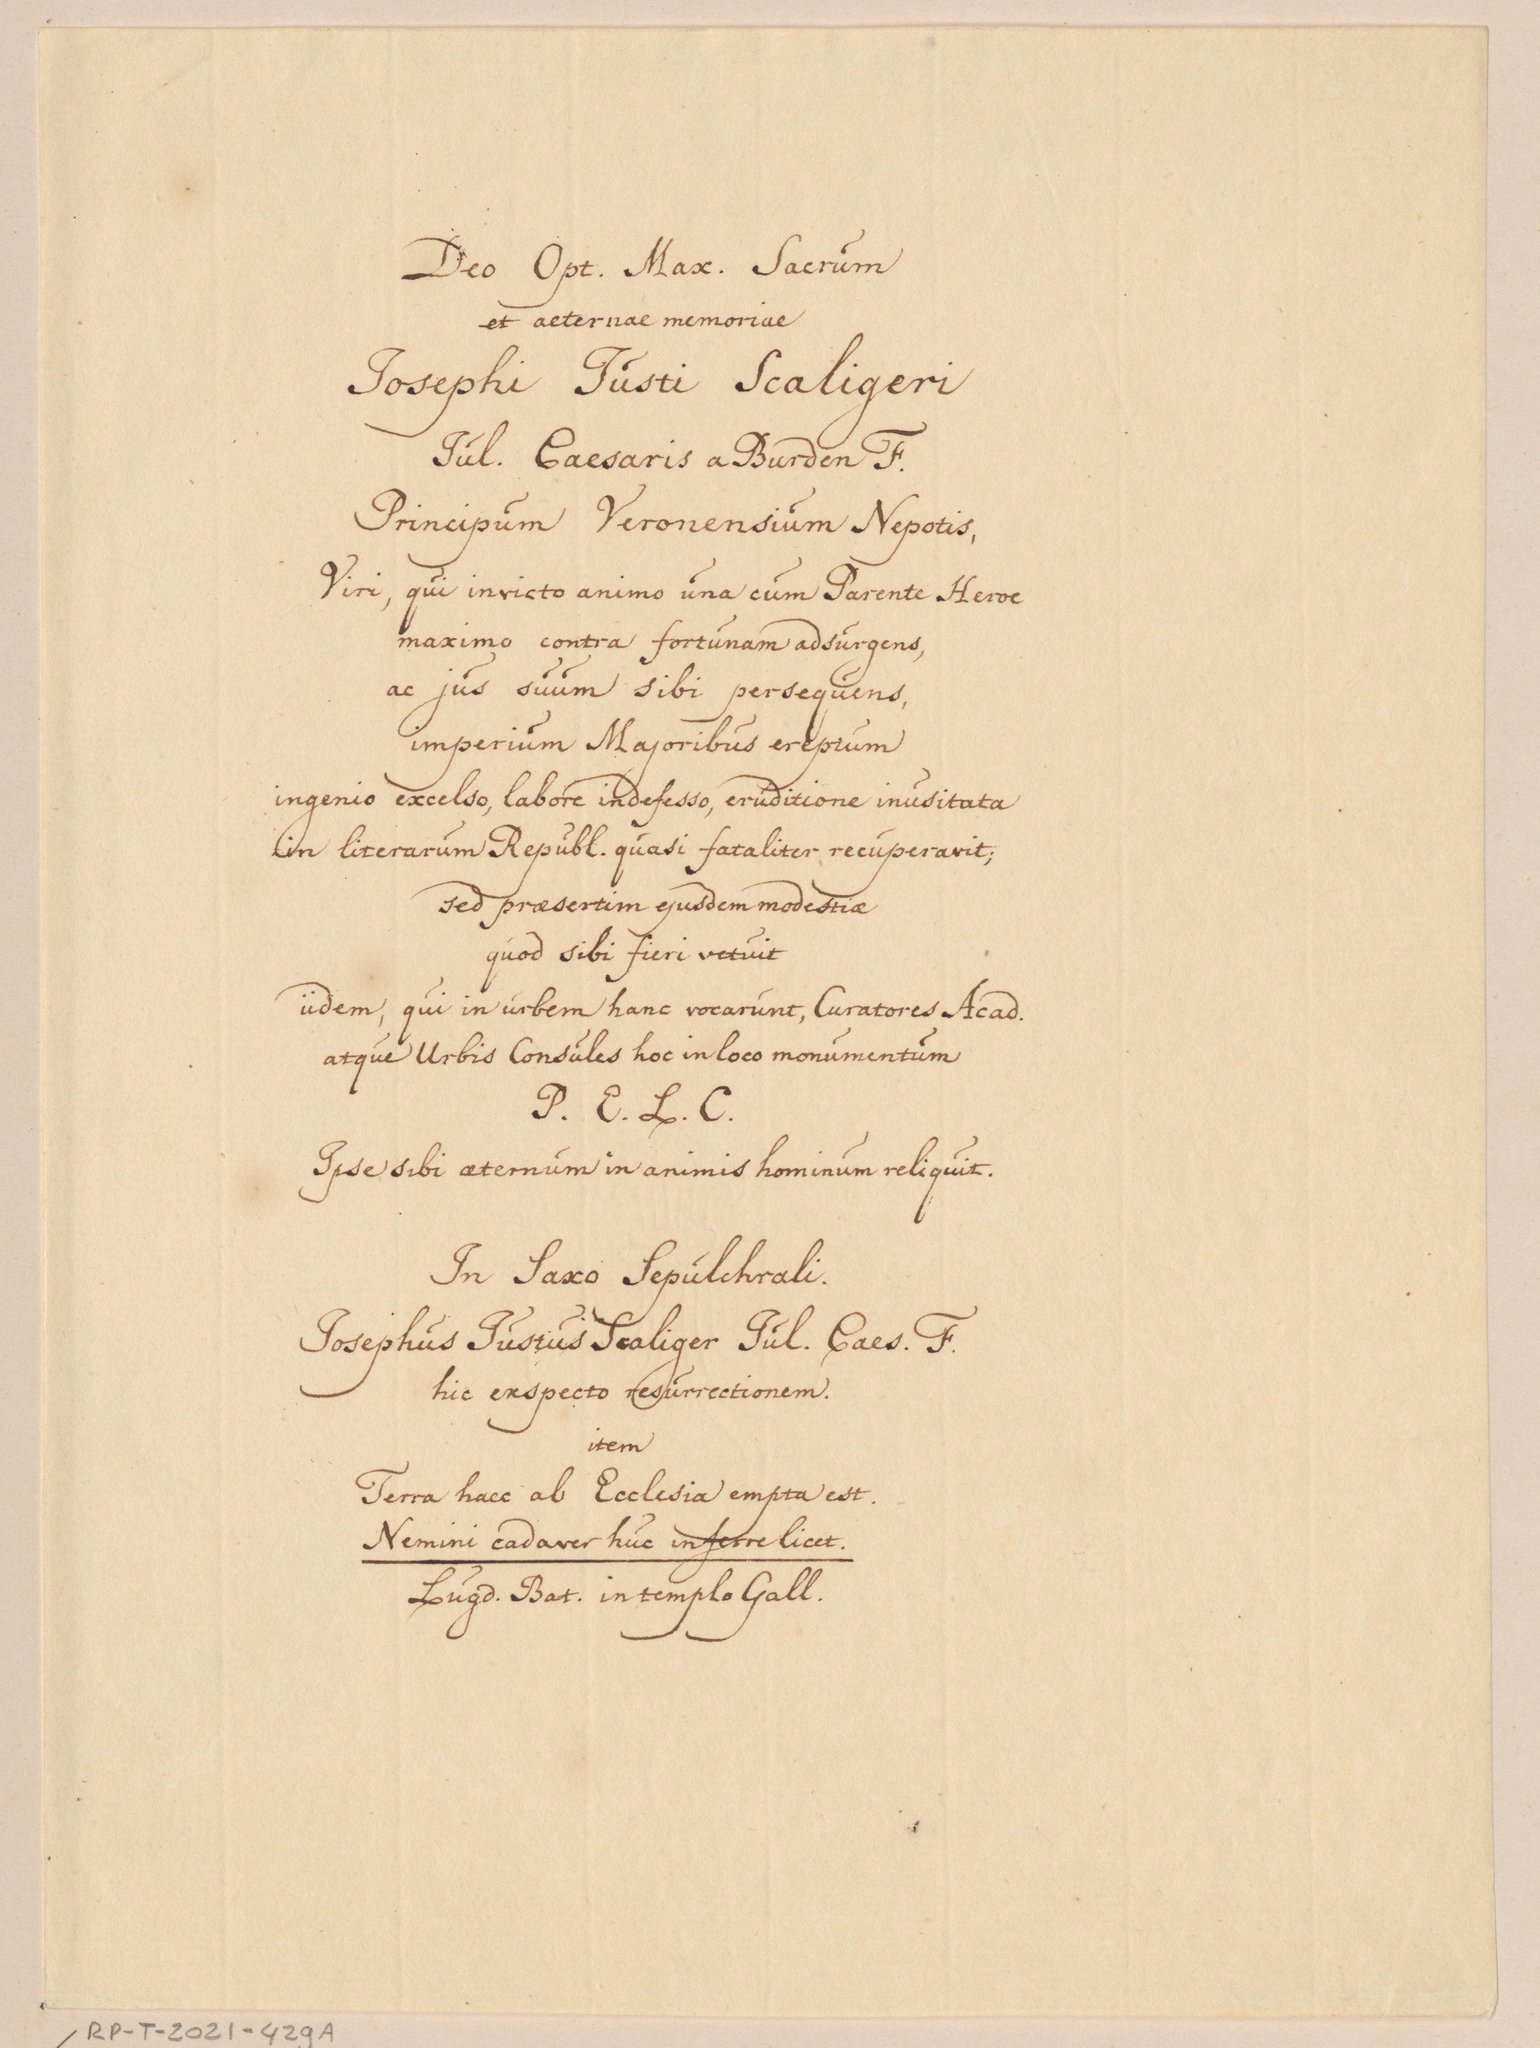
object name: text sheet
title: Tekstblad met het opschrift van het herdenkingsmonument voor Josephus Scaliger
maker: Anonymous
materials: ink, paper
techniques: pen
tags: handwriting, written text, other memorial structures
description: Dit tekstblad hoort bij een tekening van herdenkingsmonument voor Josephus Scaliger. Op hetzelfde opzetvel van de tekening zit een tweede blad bevestigd met de vermelding dat het herdenkingsmonument voor Josephus Scaliger in 1819 van de Vrouwekerk naar de Pieterskerk in Leiden is overgebracht.